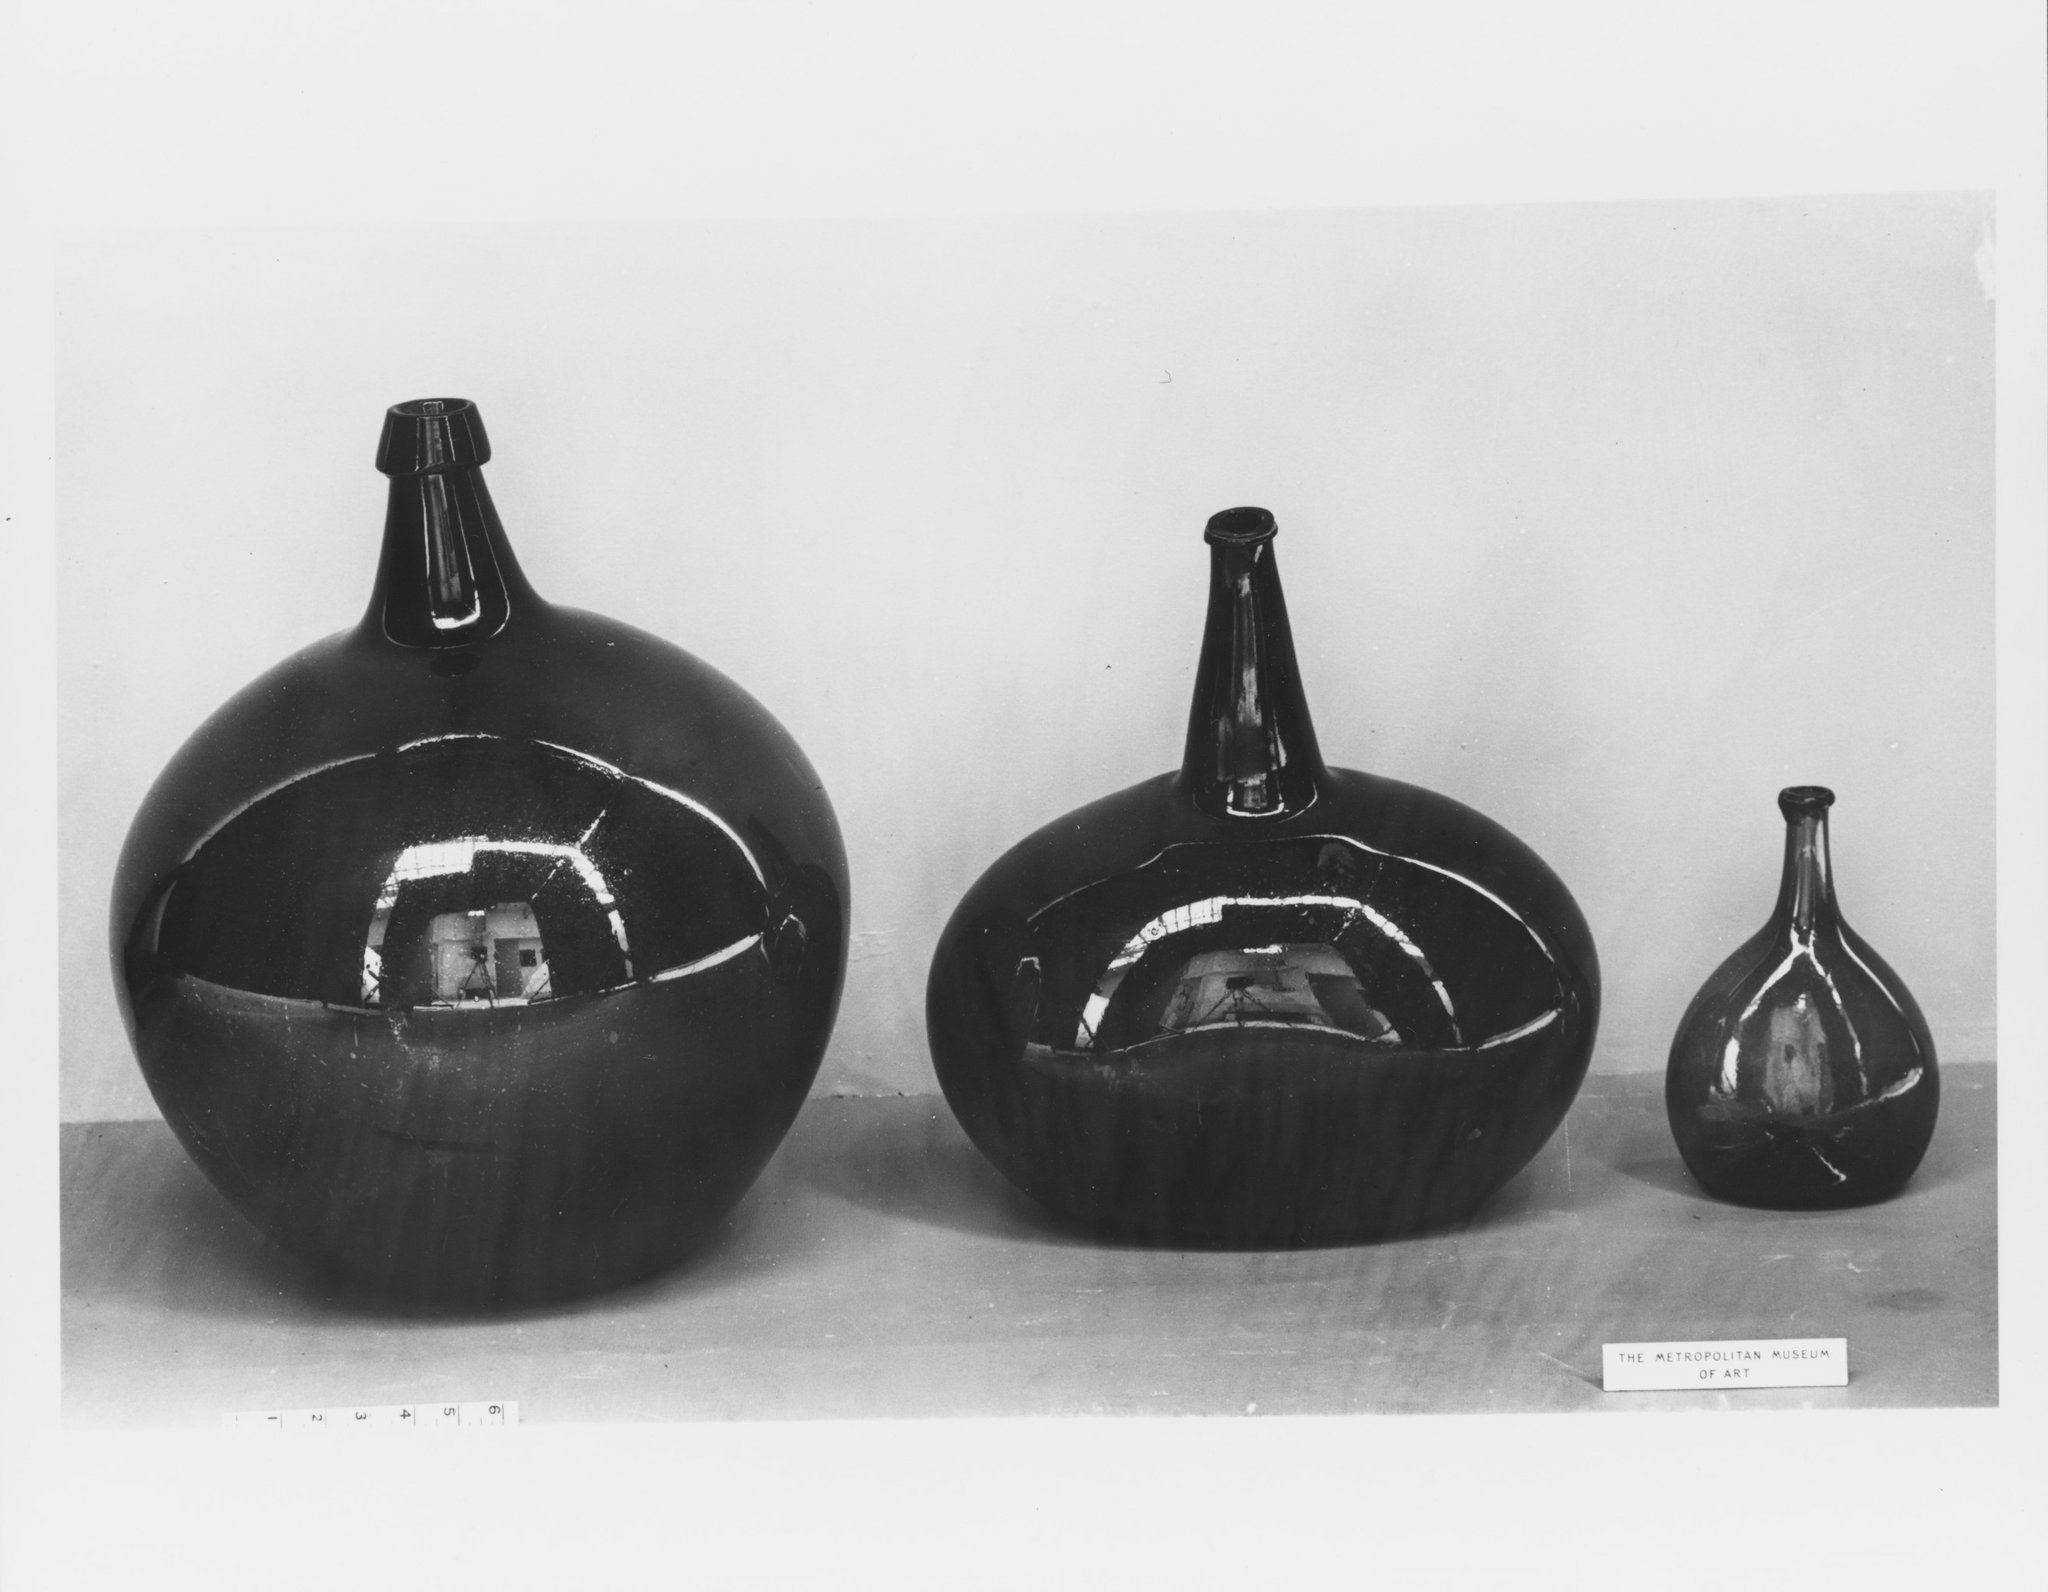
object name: bottle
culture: american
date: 1800-1900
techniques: glassblowing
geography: united states